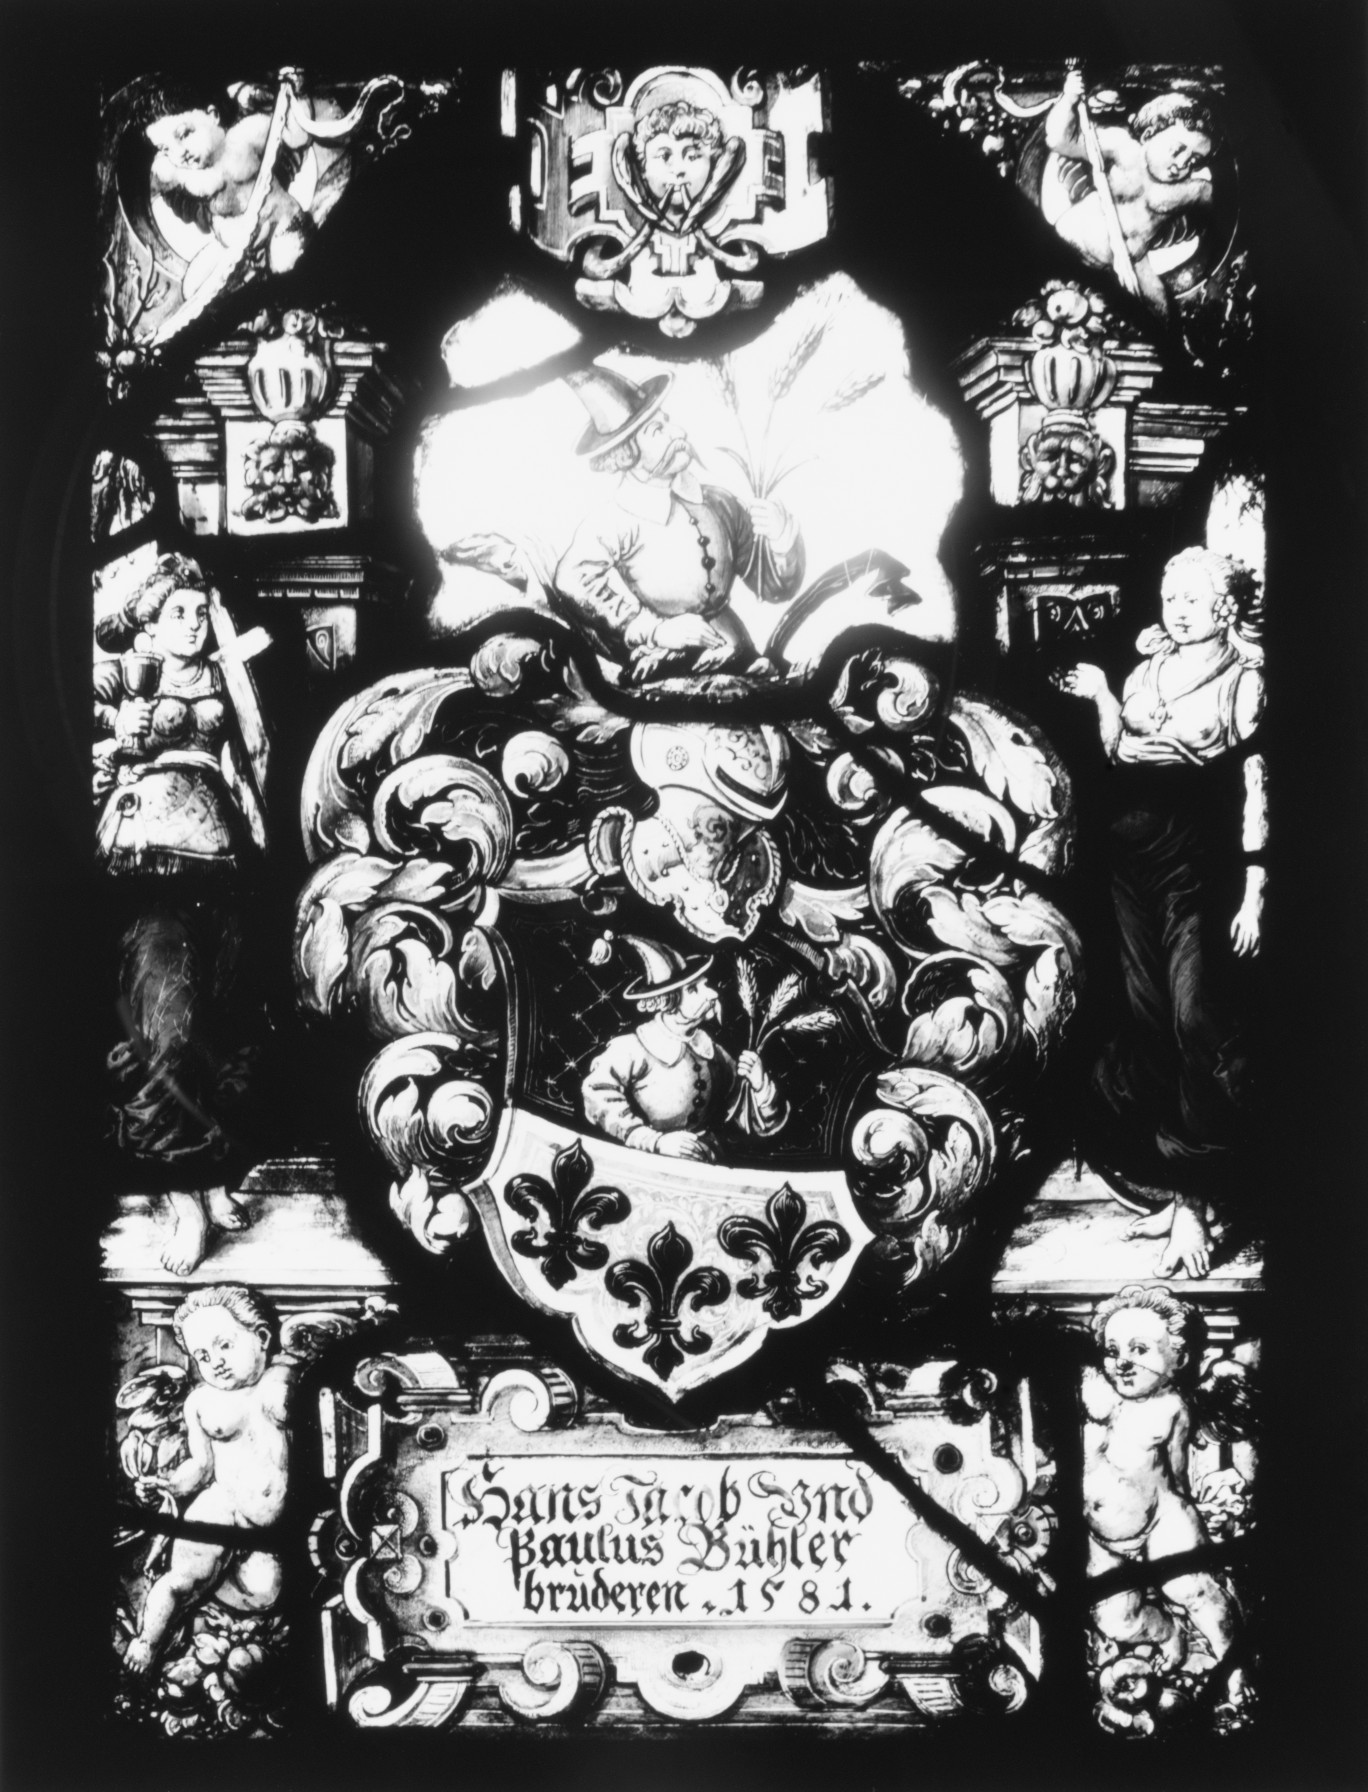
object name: armorial panel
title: Arms of the Bühler family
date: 1581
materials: glass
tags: coat of arms